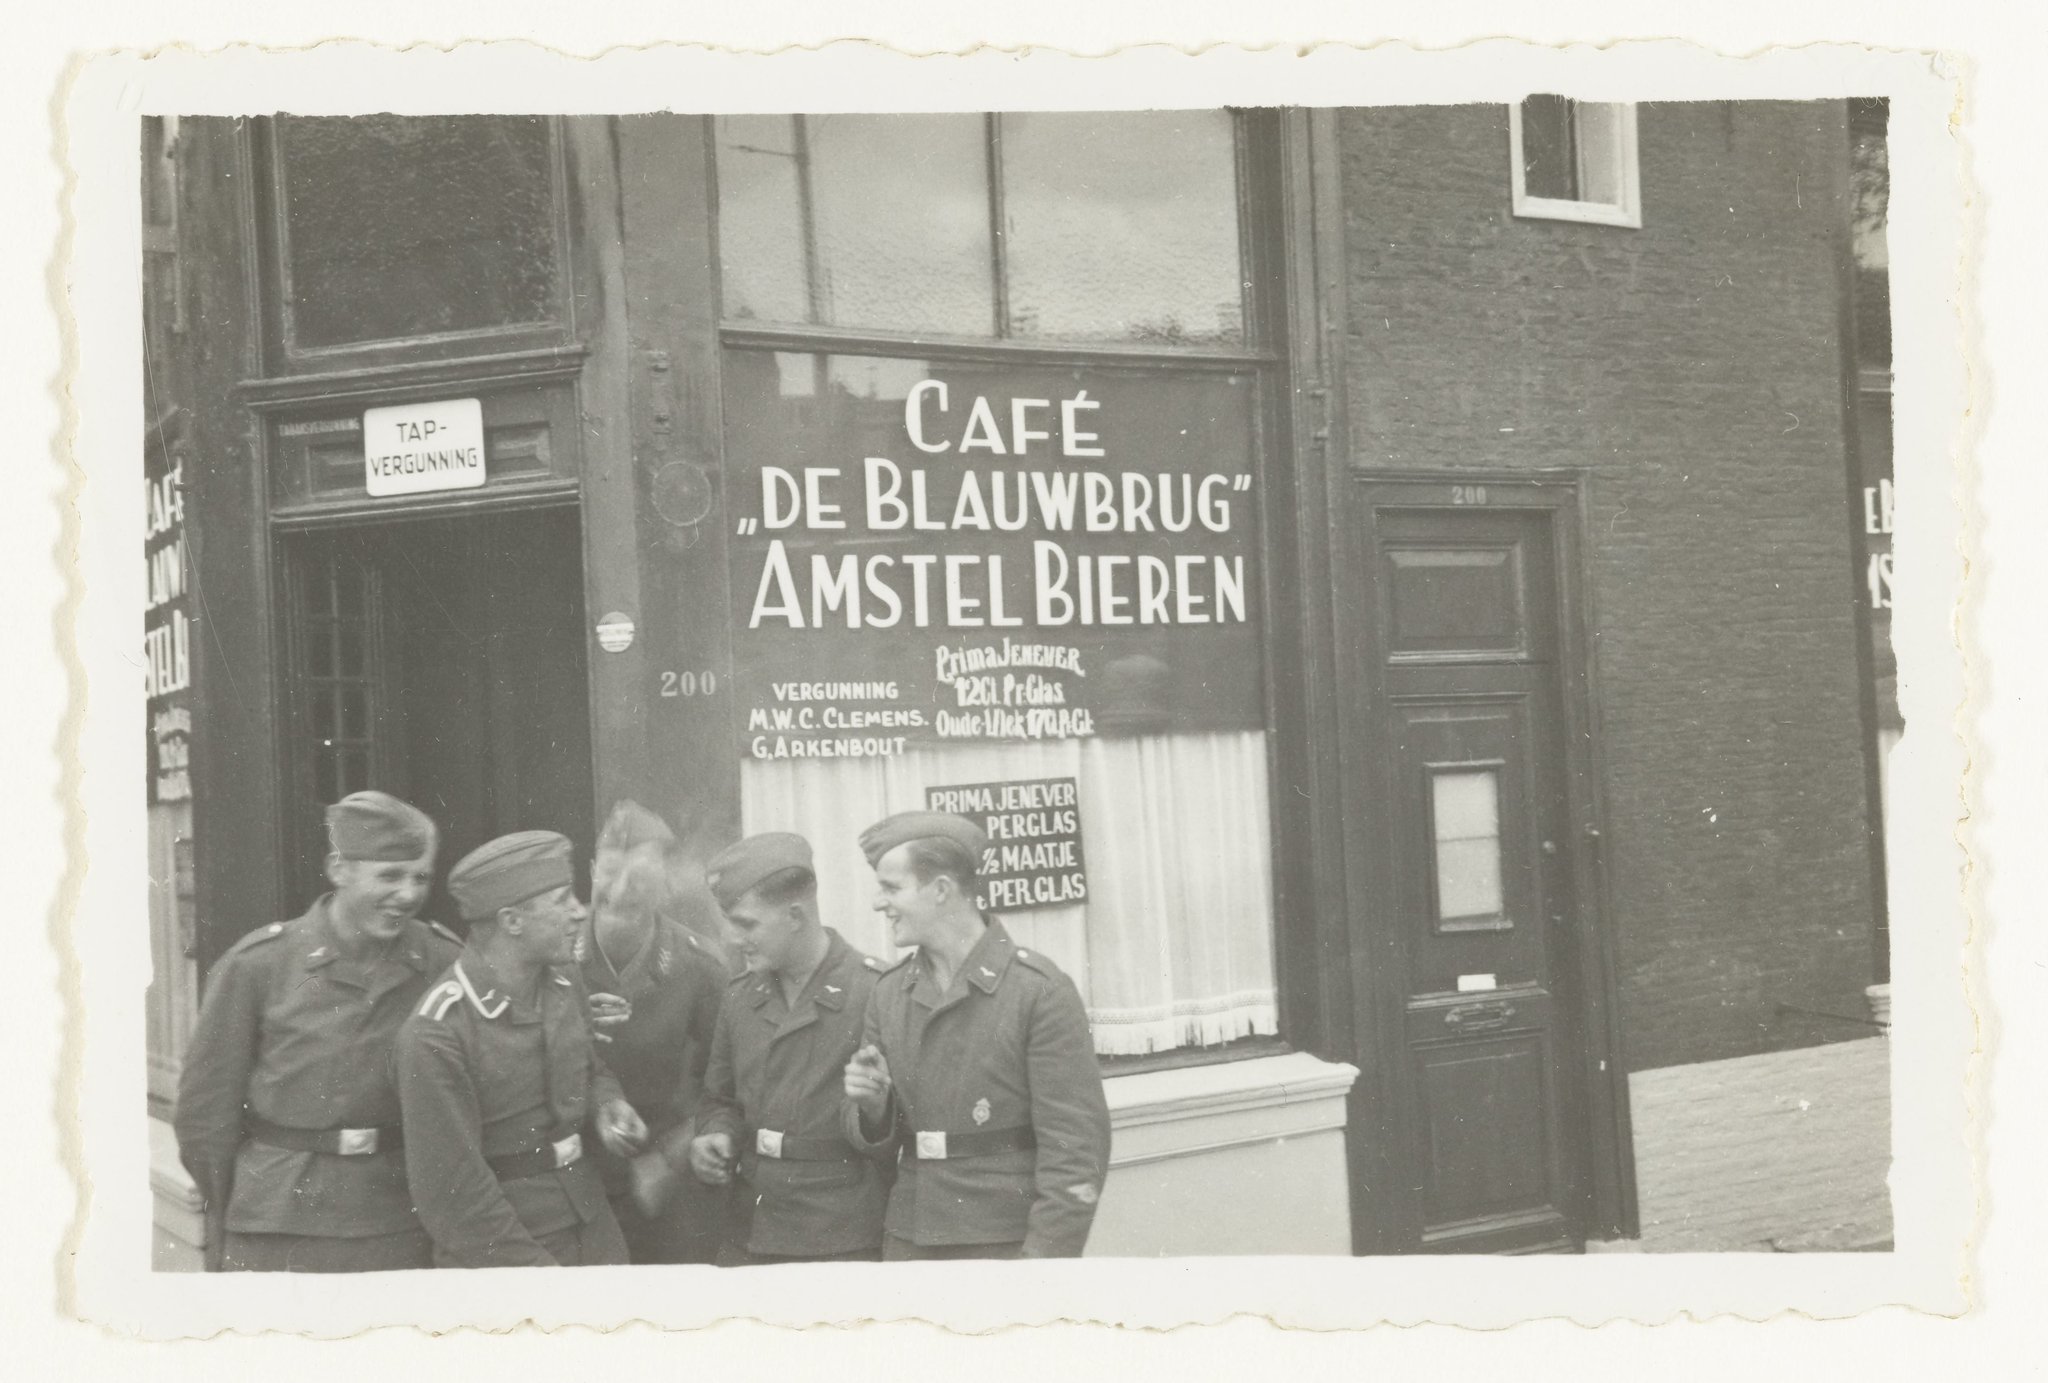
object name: photograph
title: Duitse soldaten voor café "de Blauwbrug"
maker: Anonymous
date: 1941-1943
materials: photographic support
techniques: gelatin silver print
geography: amsterdam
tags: recreation ~ the soldier off duty, occupation ~ war, amsterdam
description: Vijf Duitse soldaten van de Wehrmacht staan voor een café: "De Blauwbrug", in het centrum van Amsterdam bij de Amstel. Het café verkoopt Amstelbieren en prima jenever per glas. Achterop staat: Bei einem Ausflug in Amsterdam.